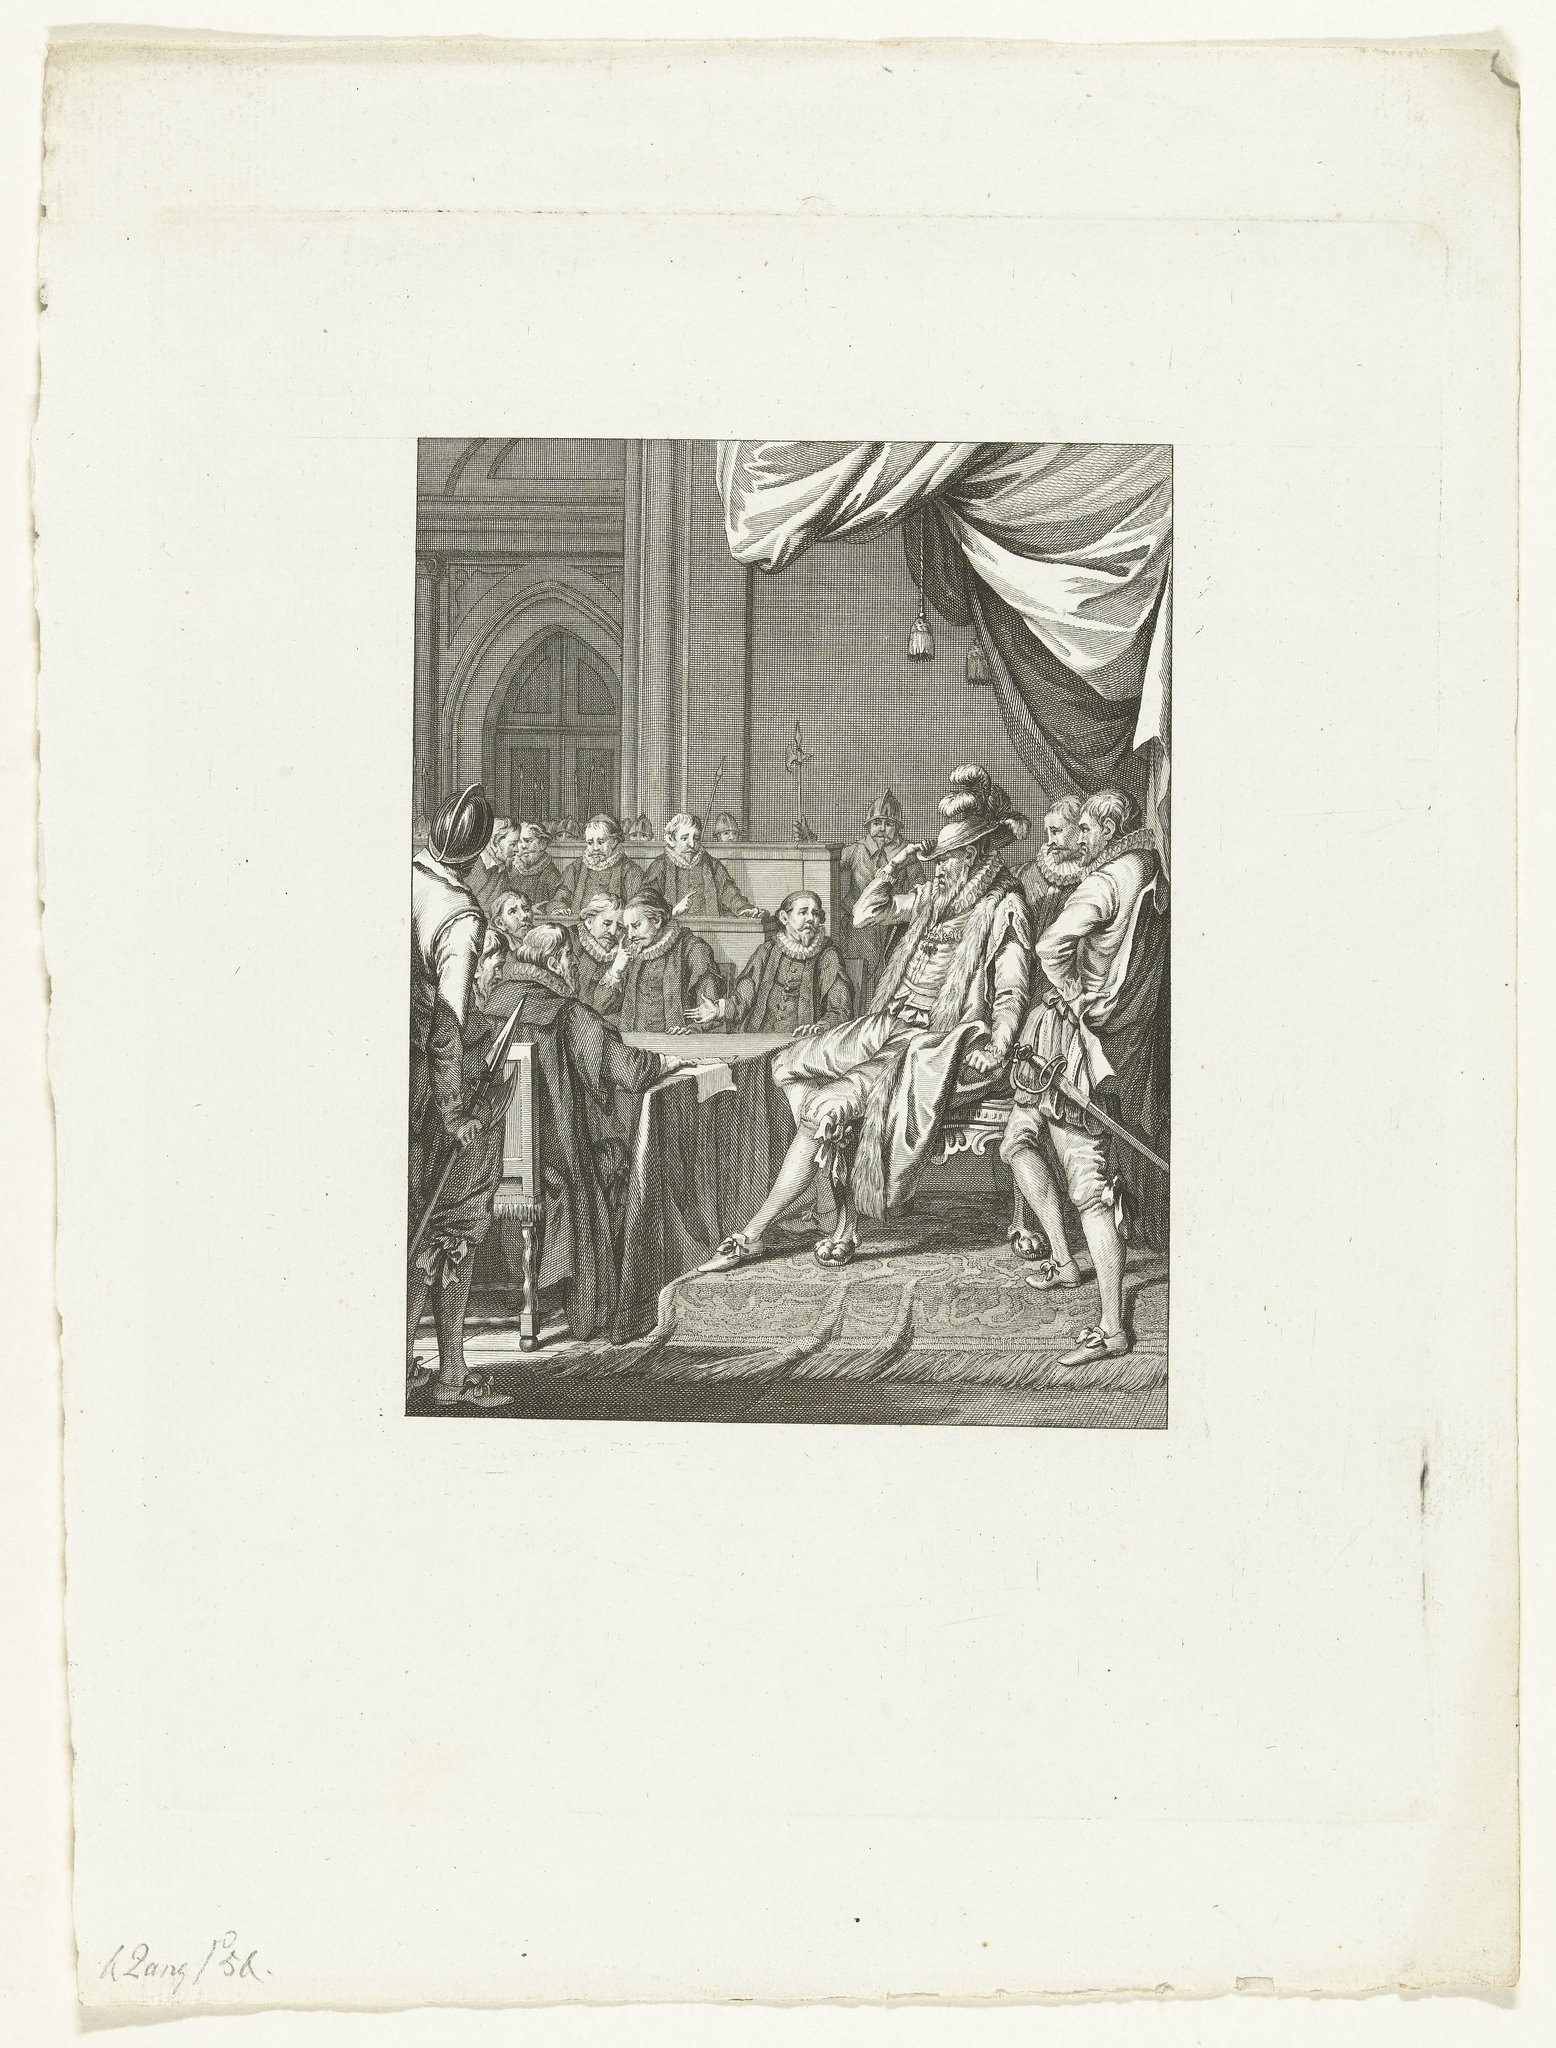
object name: print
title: Vordering v.d. Tienden Penning / IV. zang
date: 1779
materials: paper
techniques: etching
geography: amsterdam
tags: fernando álvarez de toledo (3rd duke of alba)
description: Illustratie voor: J. Nomsz, Willem de eerste, of de grondlegging der Nederlandsche vryheid. : In vier en twintig zangen, Erven van David Klippink, Amsterdam 1779. Staat vóór de letter. Groep van vier proefdrukken in de oorspronkelijke omslag van de uitgevers J. Smit en Zoon en W. Vermandel te Amsterdam, 1779 (de eerste uitgave).